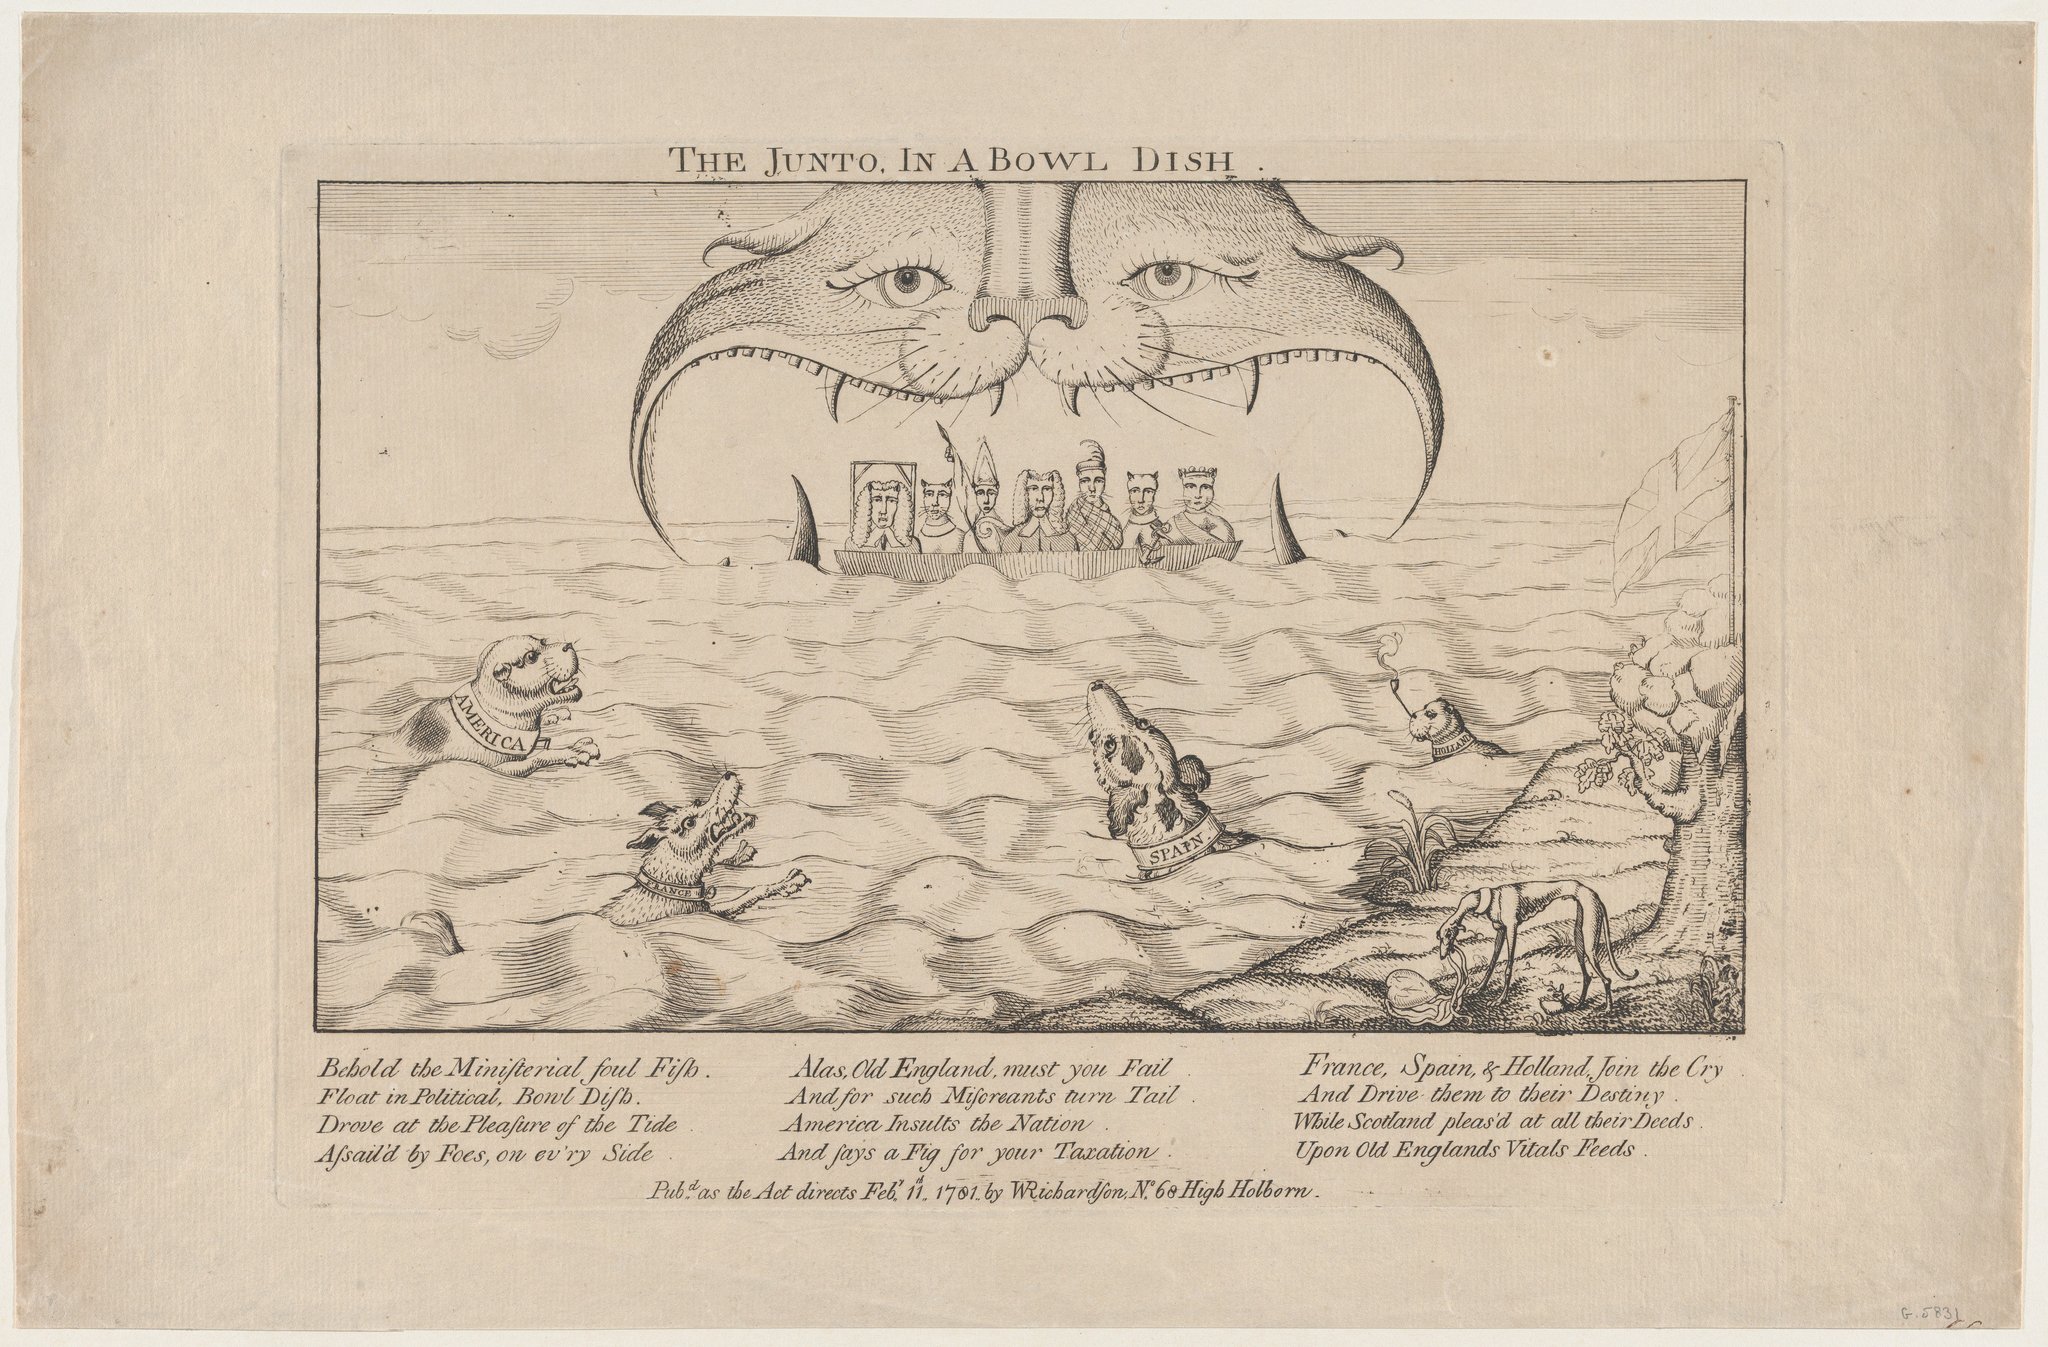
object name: print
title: The Junto in a Bowl Dish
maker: anonymous, british, 18th century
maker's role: artist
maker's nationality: british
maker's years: 1700-1800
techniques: etching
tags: satire,american revolution,monsters,dogs,politics